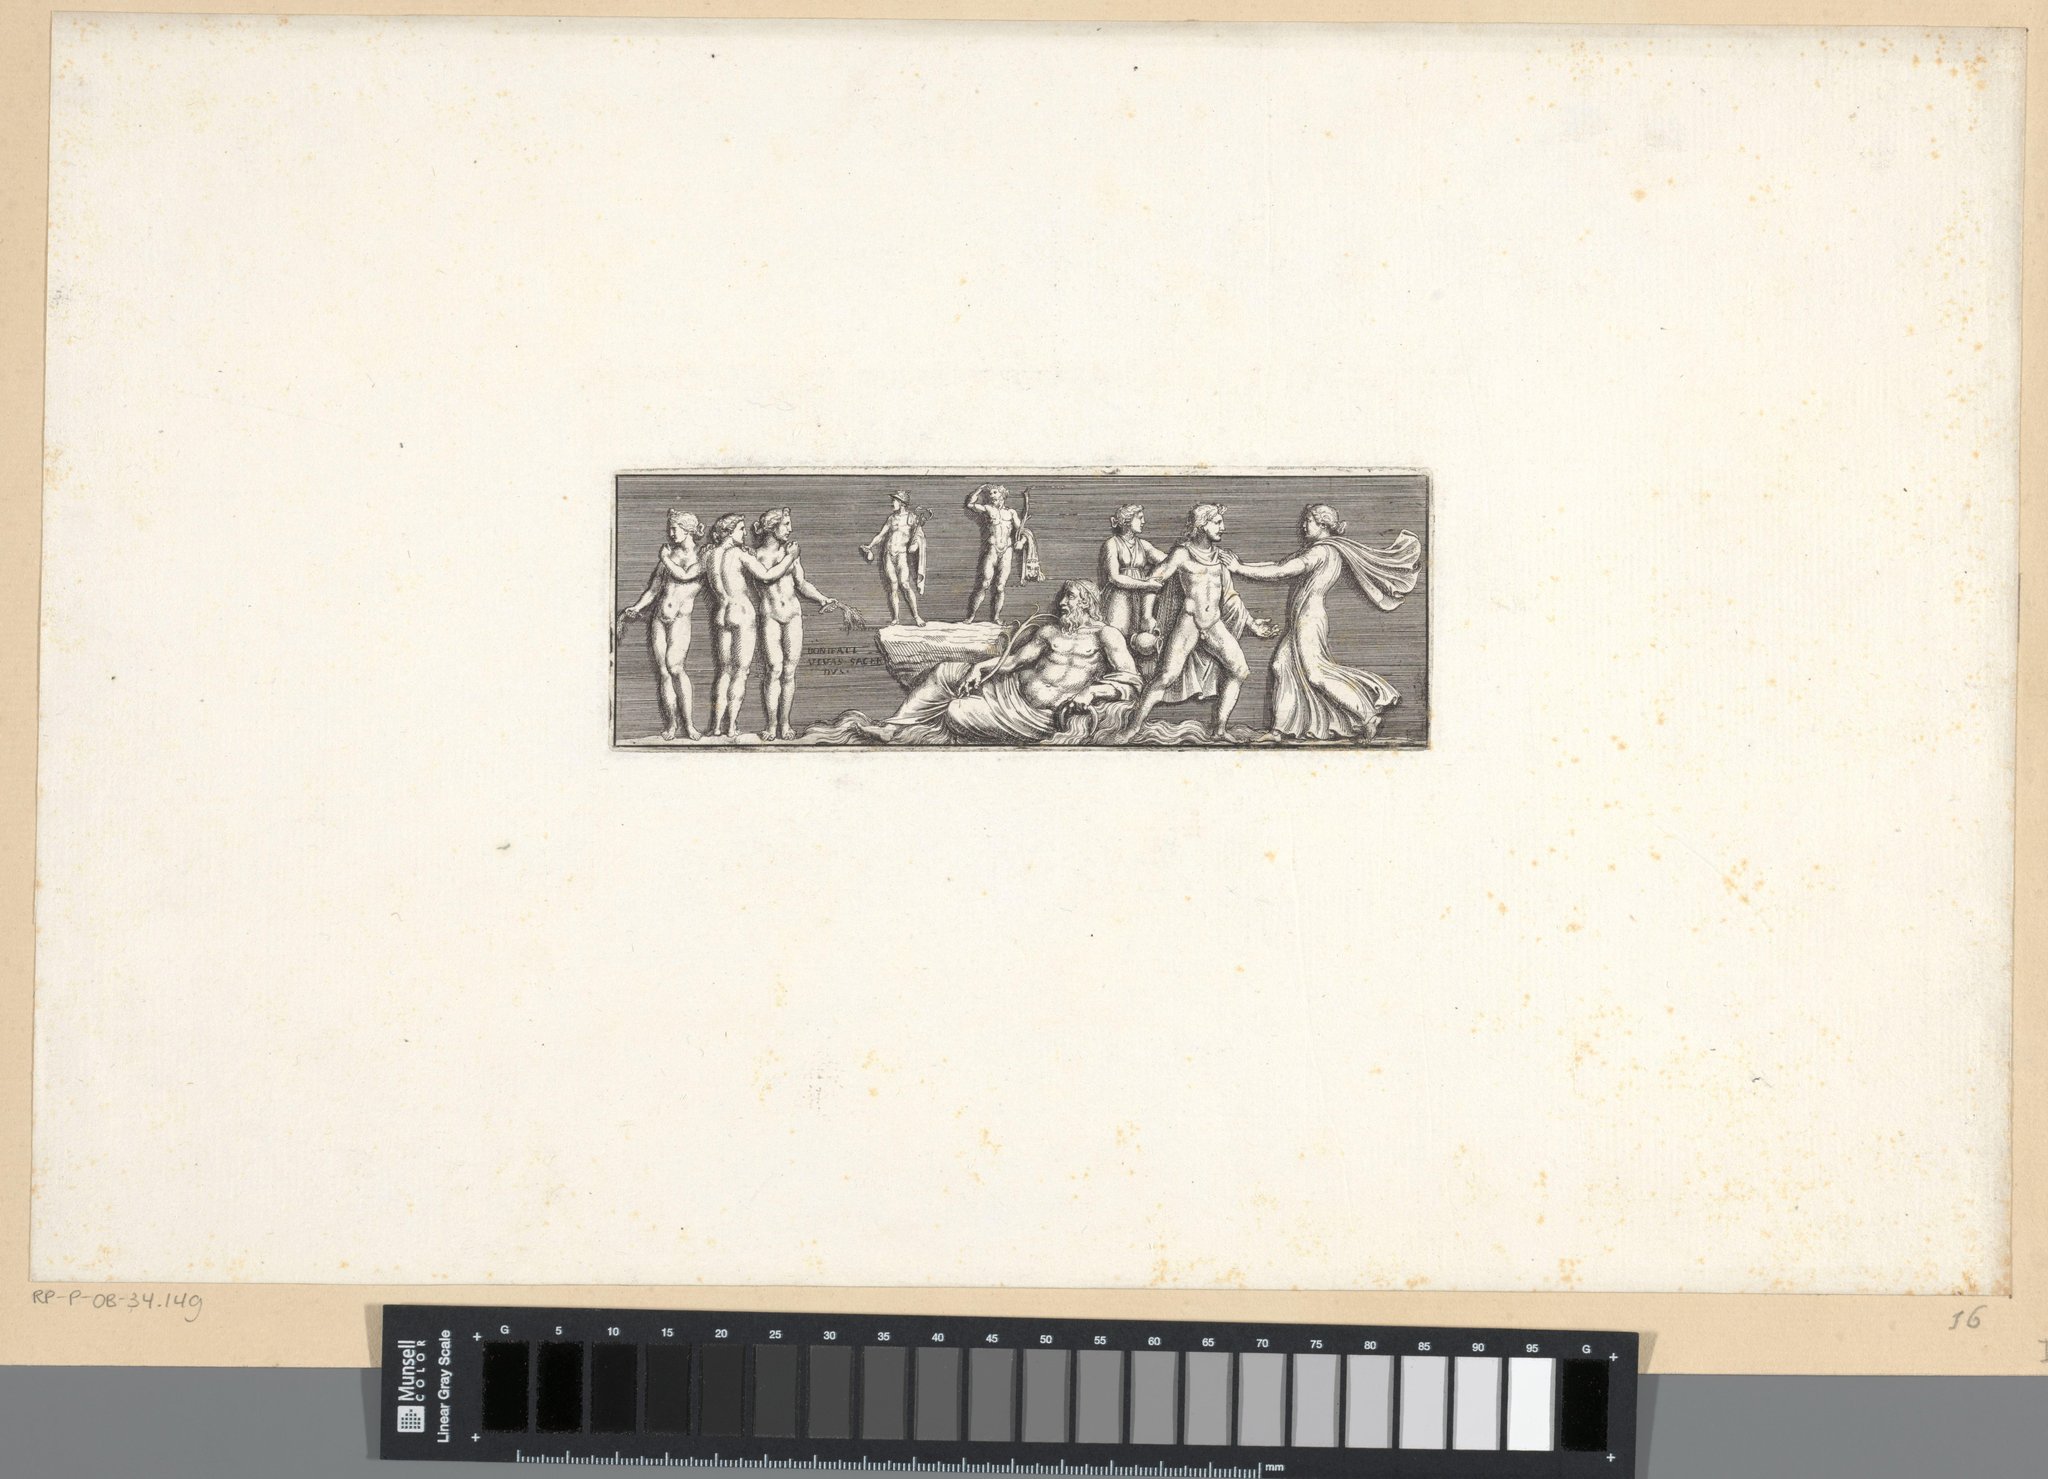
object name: print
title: Mythologische figuren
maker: pietro sante bartoli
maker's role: draughtsman, painter, print maker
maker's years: 1615-1700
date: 1645-1700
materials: paper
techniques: engraving, etching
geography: italy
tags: (story of) hercules (heracles), (story of) mercury (hermes), river-gods, graces (charites), generally three in number; 'gratie' (ripa)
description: De drie Gratiën, een riviergod, Mercurius, Hercules en een naakte mannenfiguur tussen twee mannen.